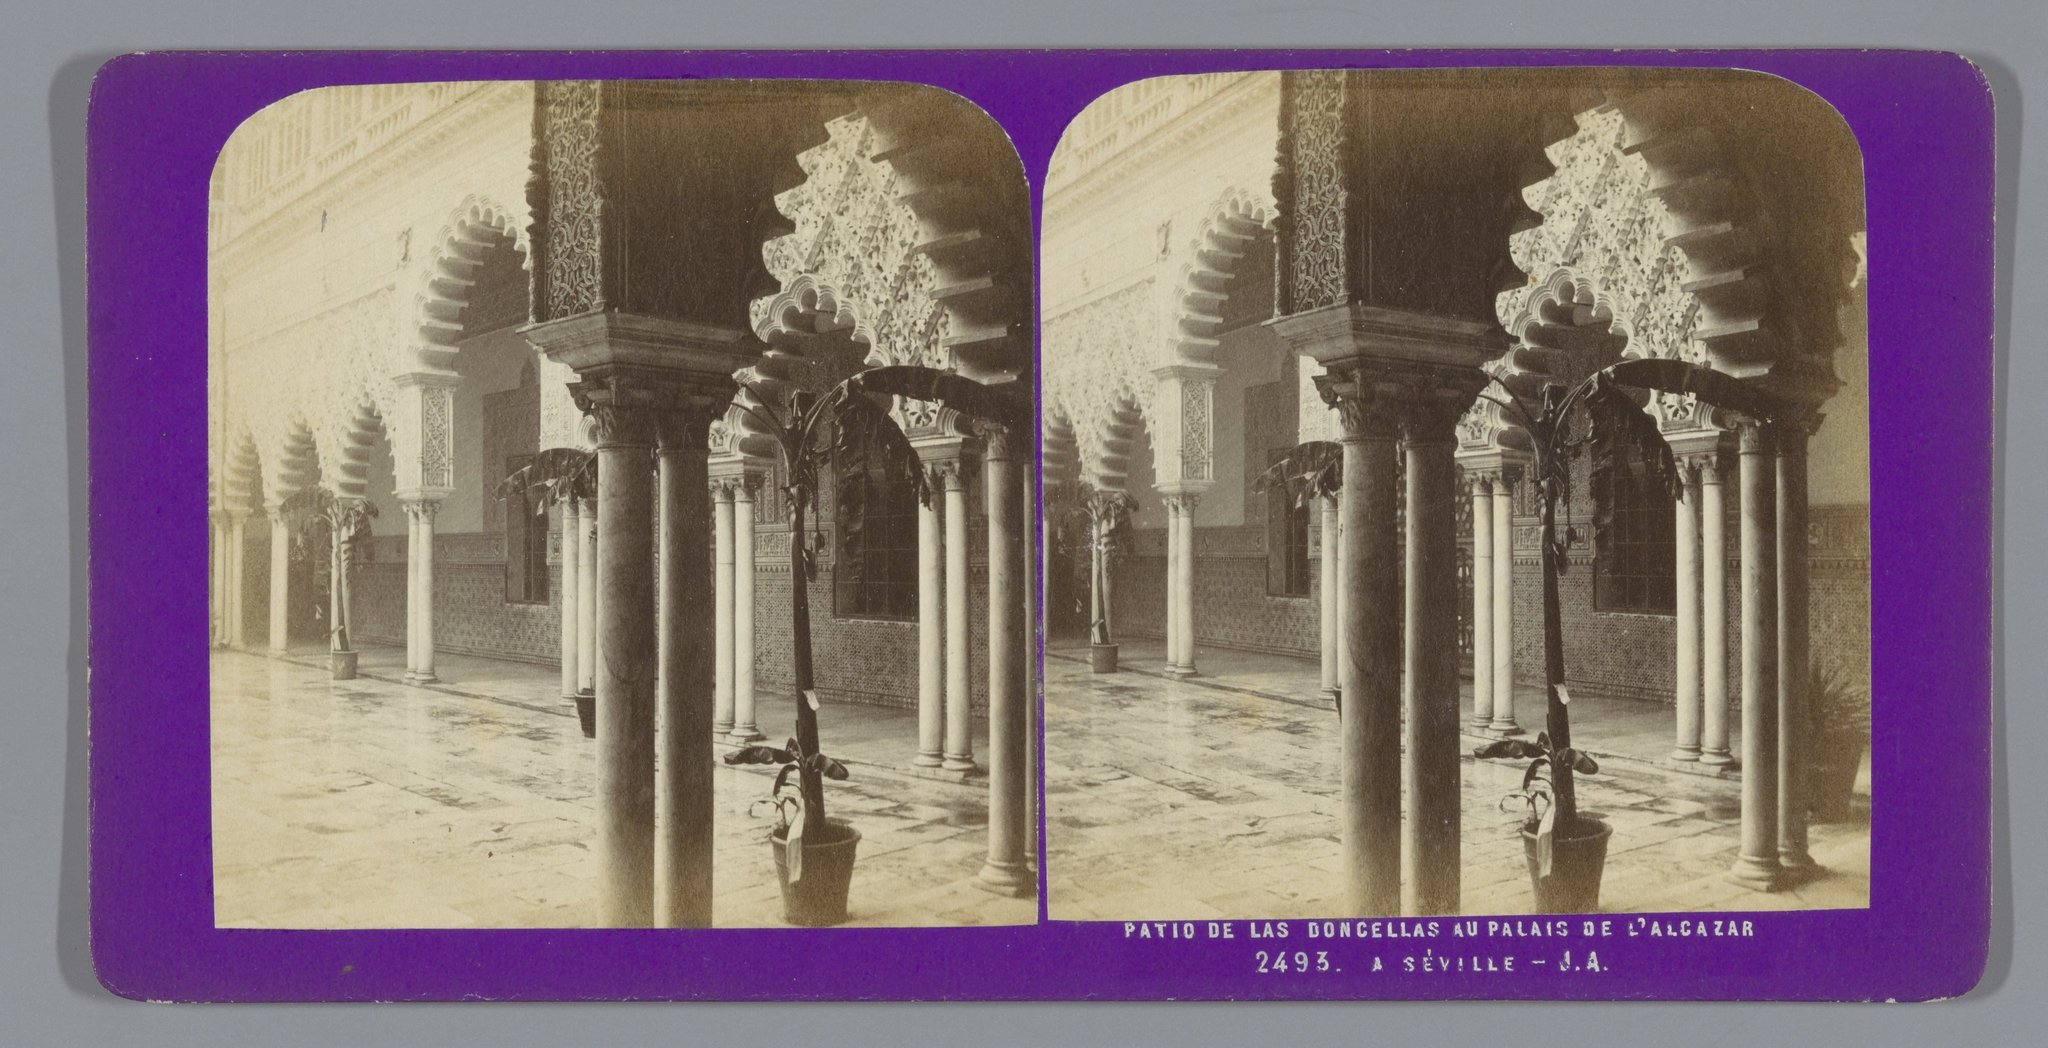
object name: stereograph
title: Gezicht op de Patio de las Doncellas in het Alcazar in Sevilla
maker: jean andrieu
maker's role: fotograaf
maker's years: 1816-1872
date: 1862-1876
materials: cardboard, photographic support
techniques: albumen print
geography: royal palace of seville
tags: arch, archivolt ~ architecture, courtyard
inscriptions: number: ‘2493.’